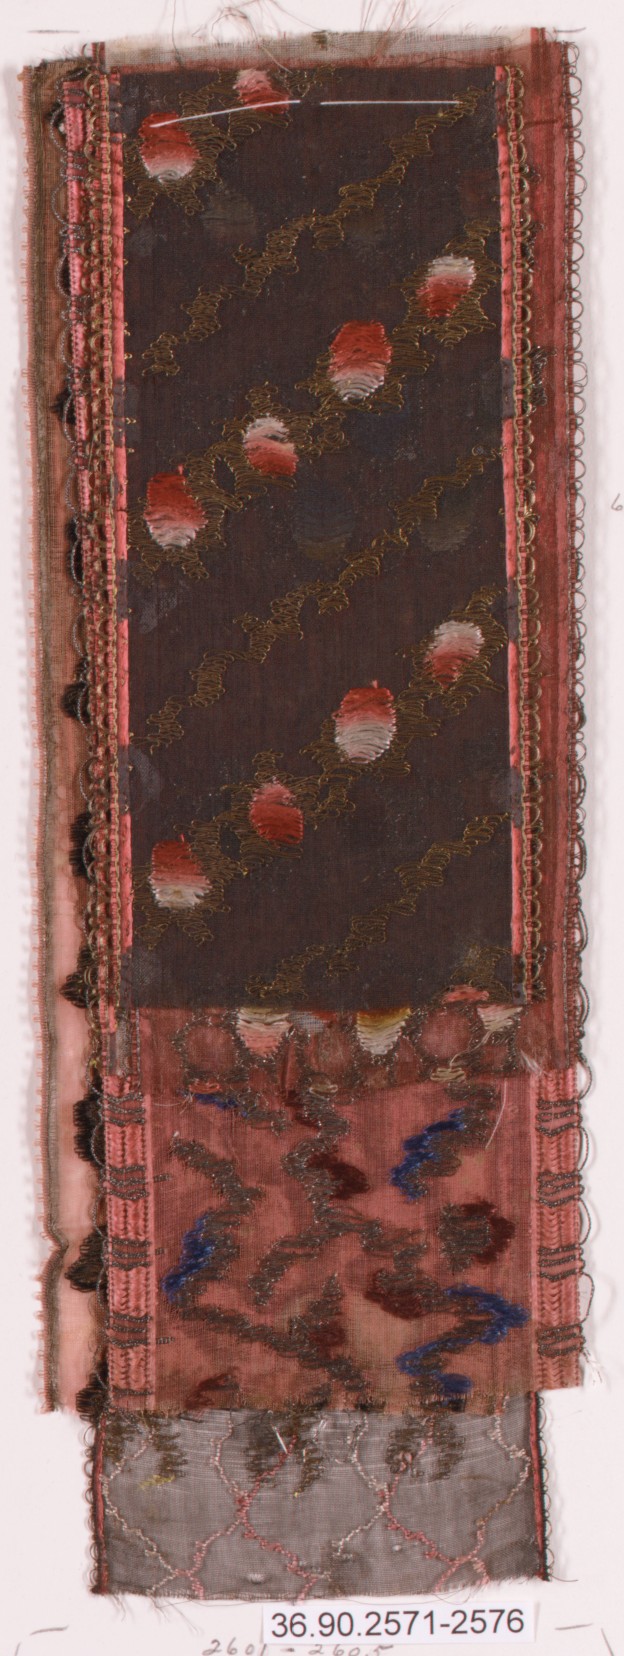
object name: ribbon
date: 1801-1900